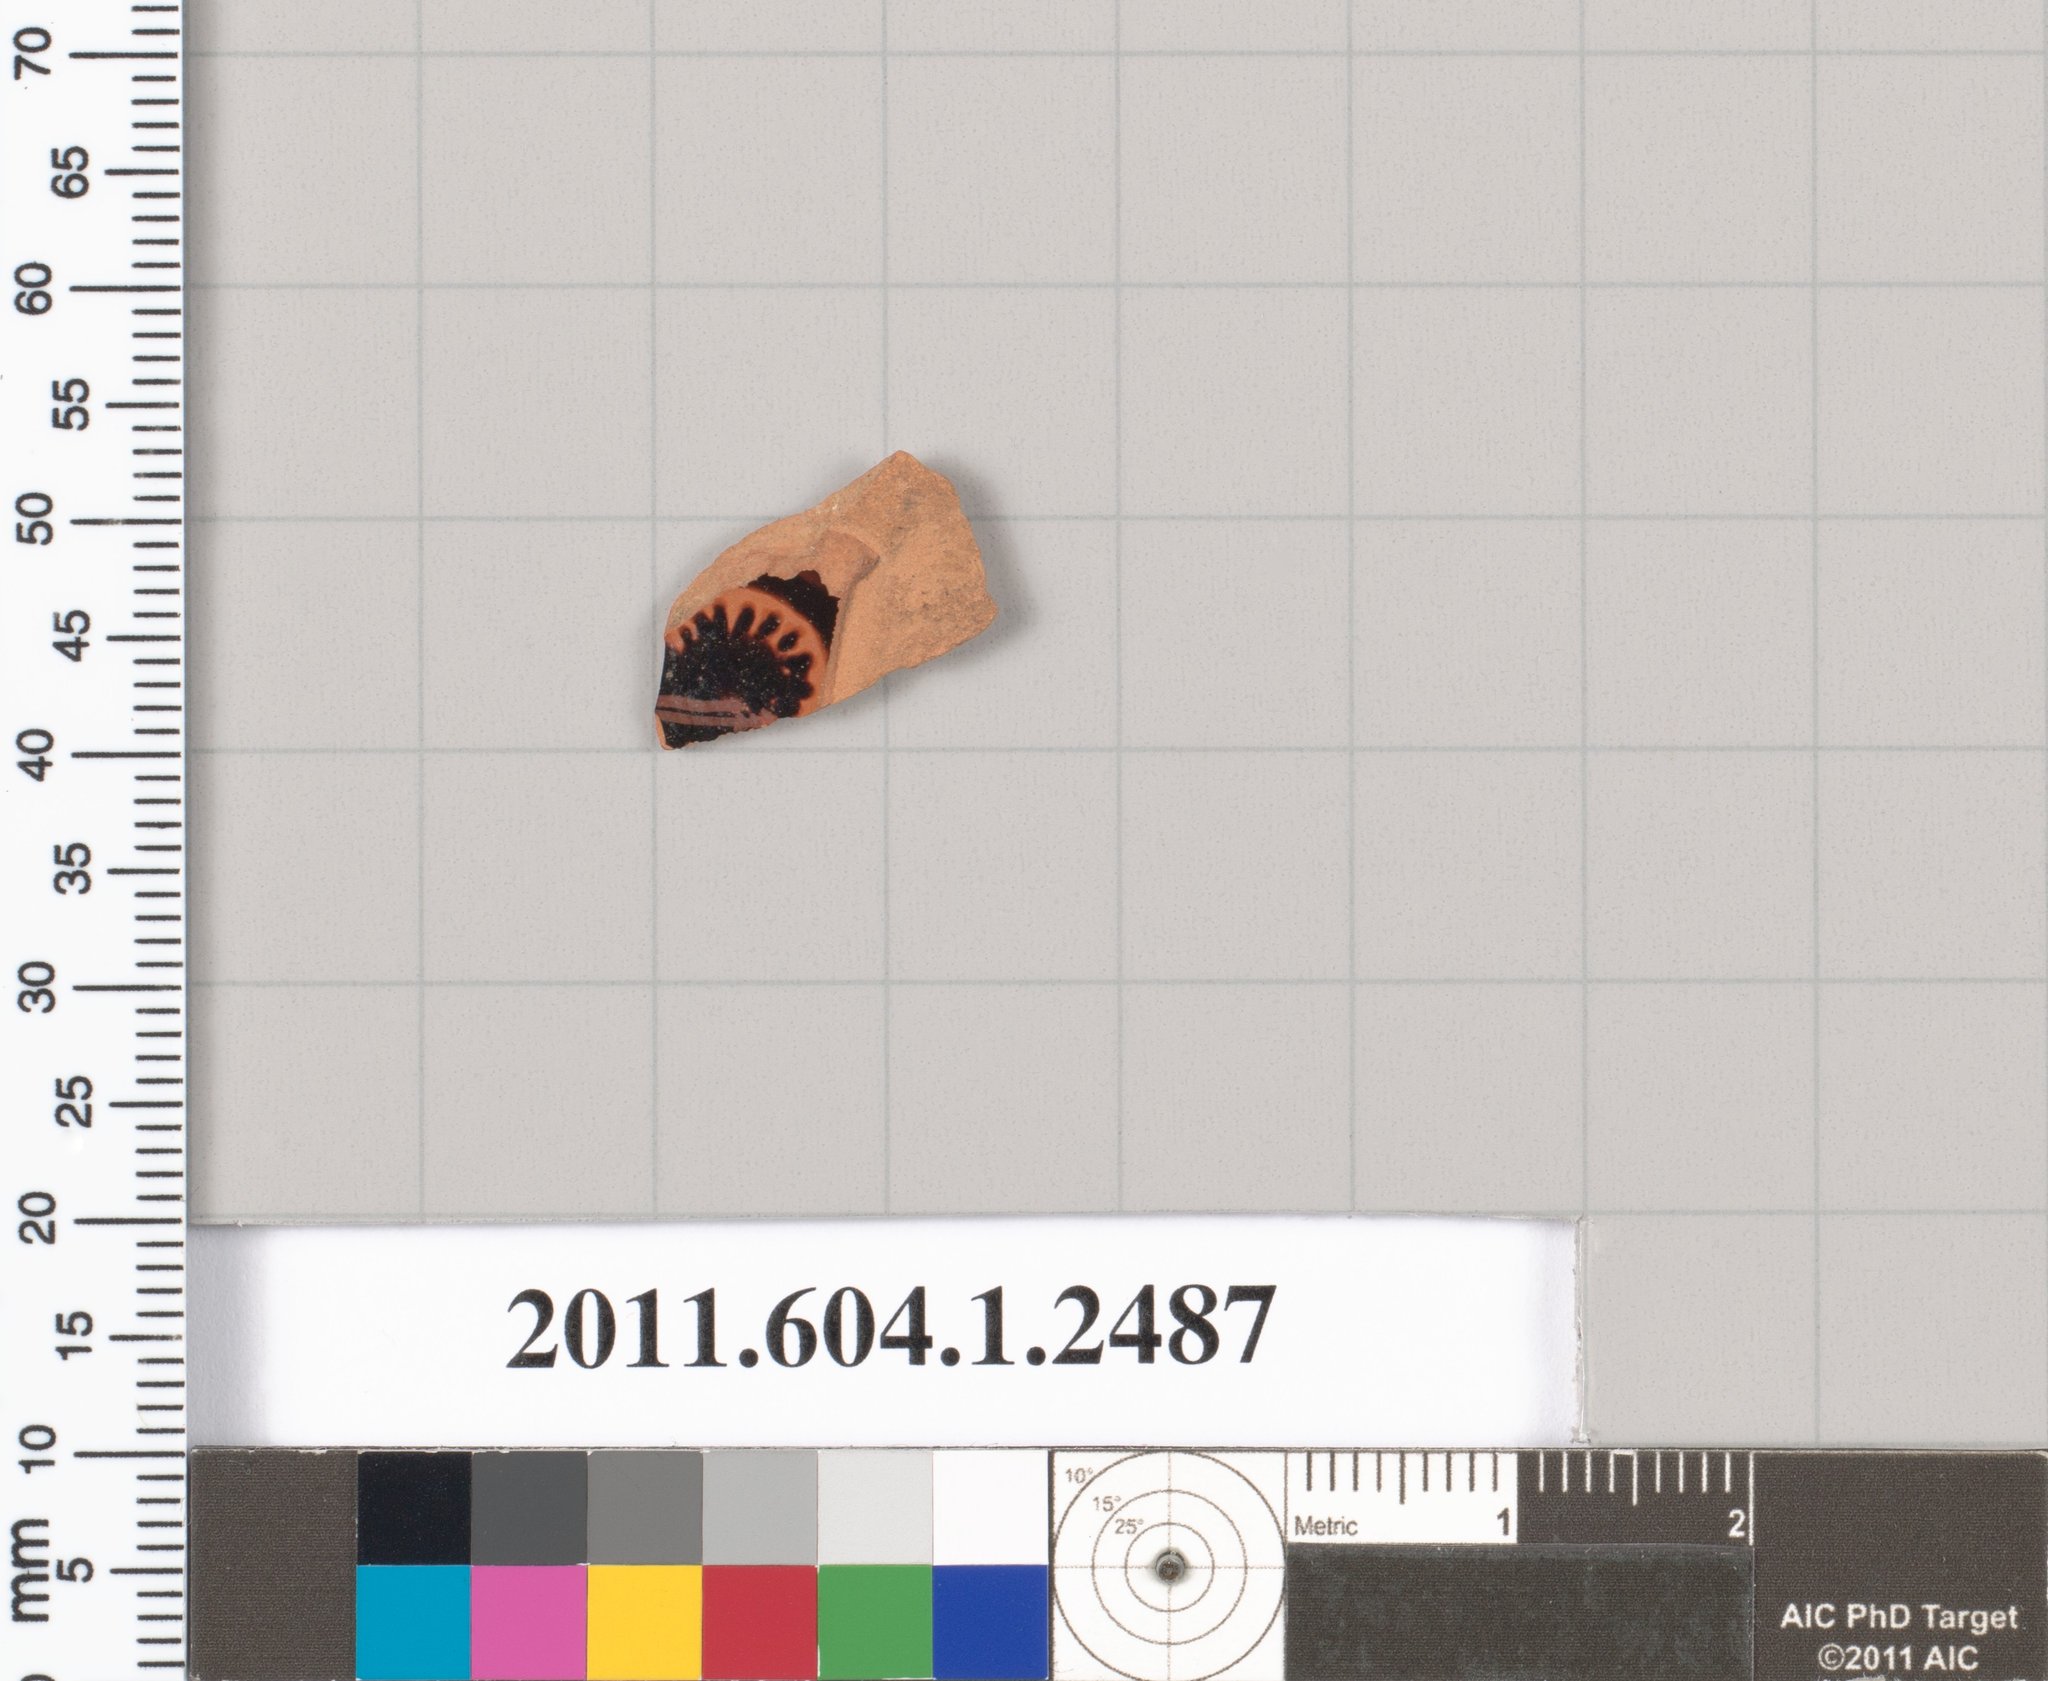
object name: kylix fragment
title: Terracotta fragment of a kylix (drinking cup)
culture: greek, attic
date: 520-500 BCE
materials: terracotta